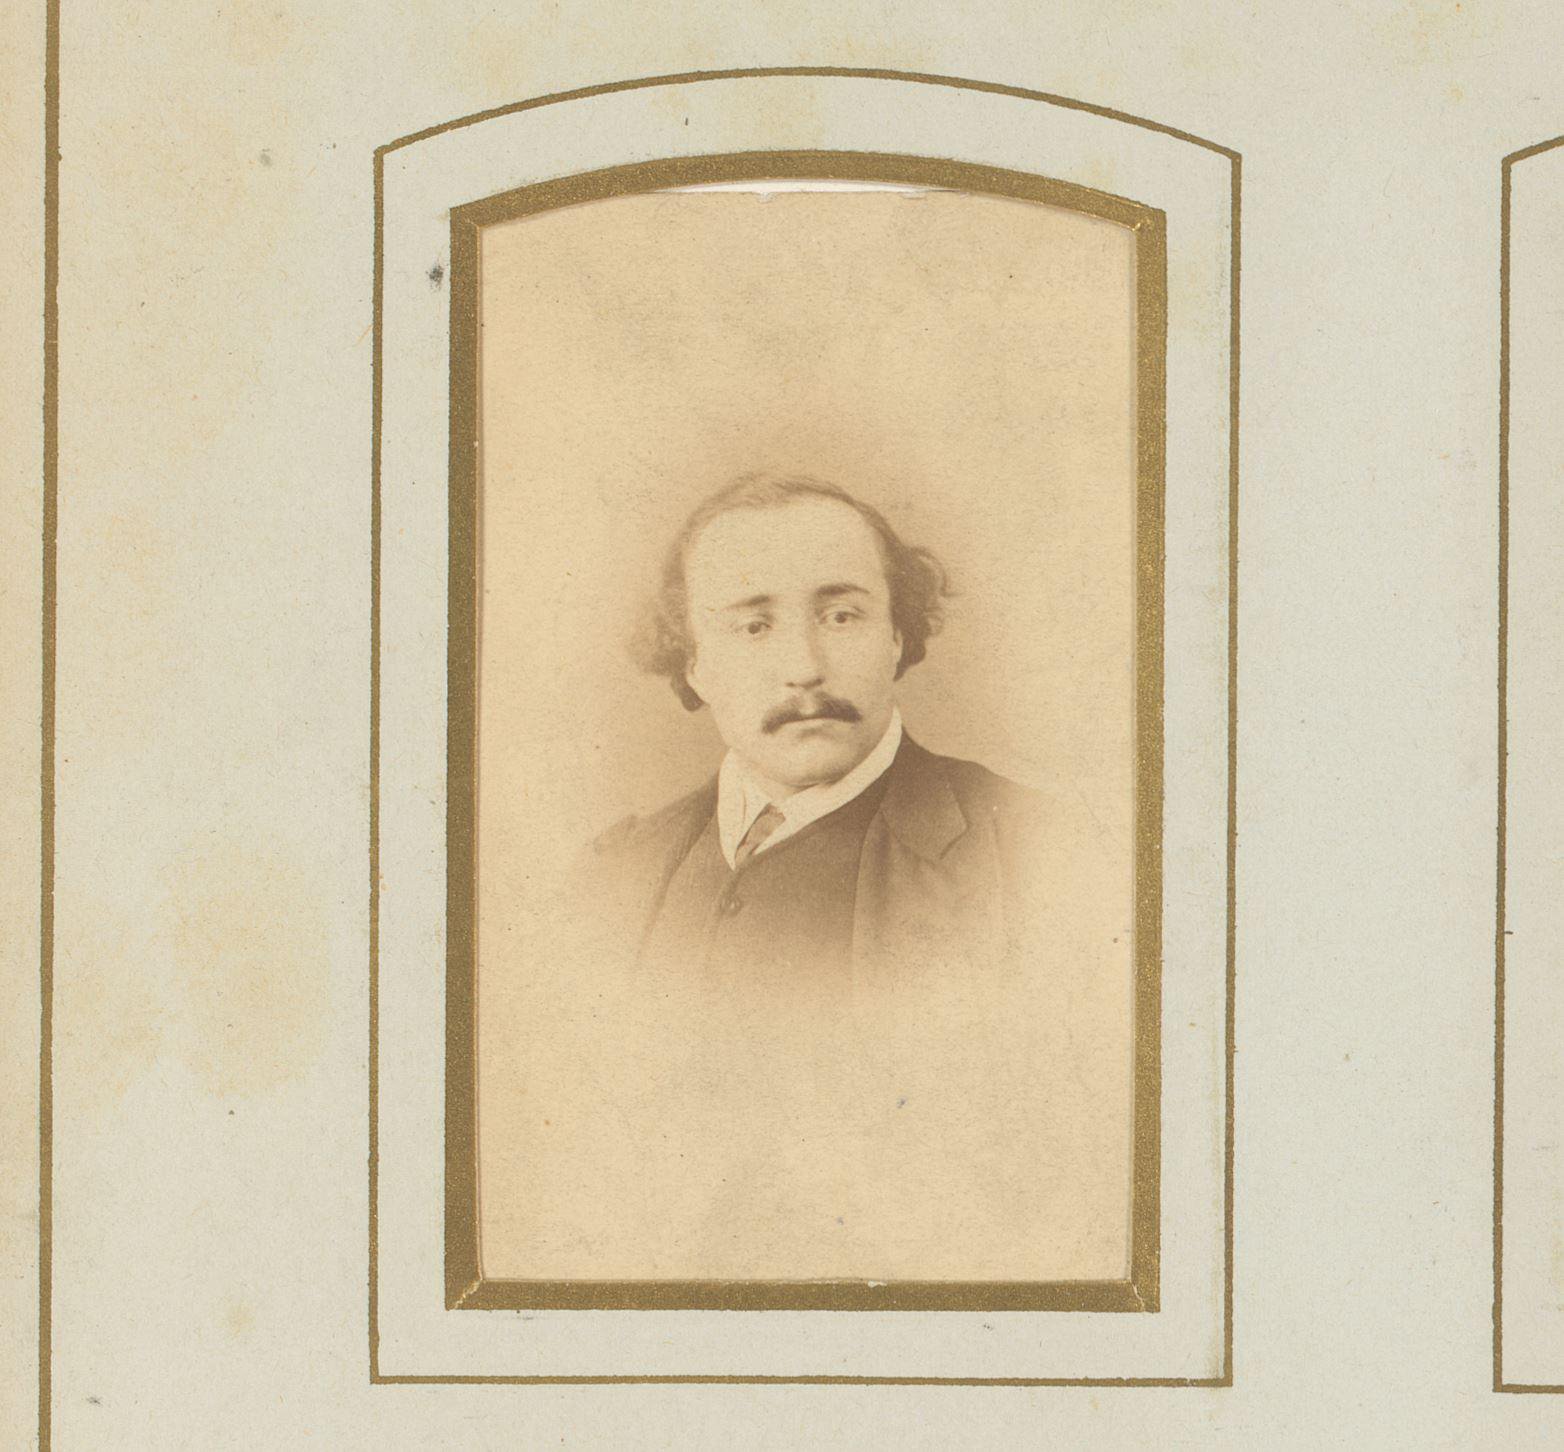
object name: carte de visite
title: Portret van een man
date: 1850-1900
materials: cardboard, photographic support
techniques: albumen print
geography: paris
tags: historical persons - bb - woman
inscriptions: inscription: ‘Photographie des Souvenirs./ 151, BOULEVARD MONTPARNASSE/ PARIS./ Reproduction et Agrandissement’